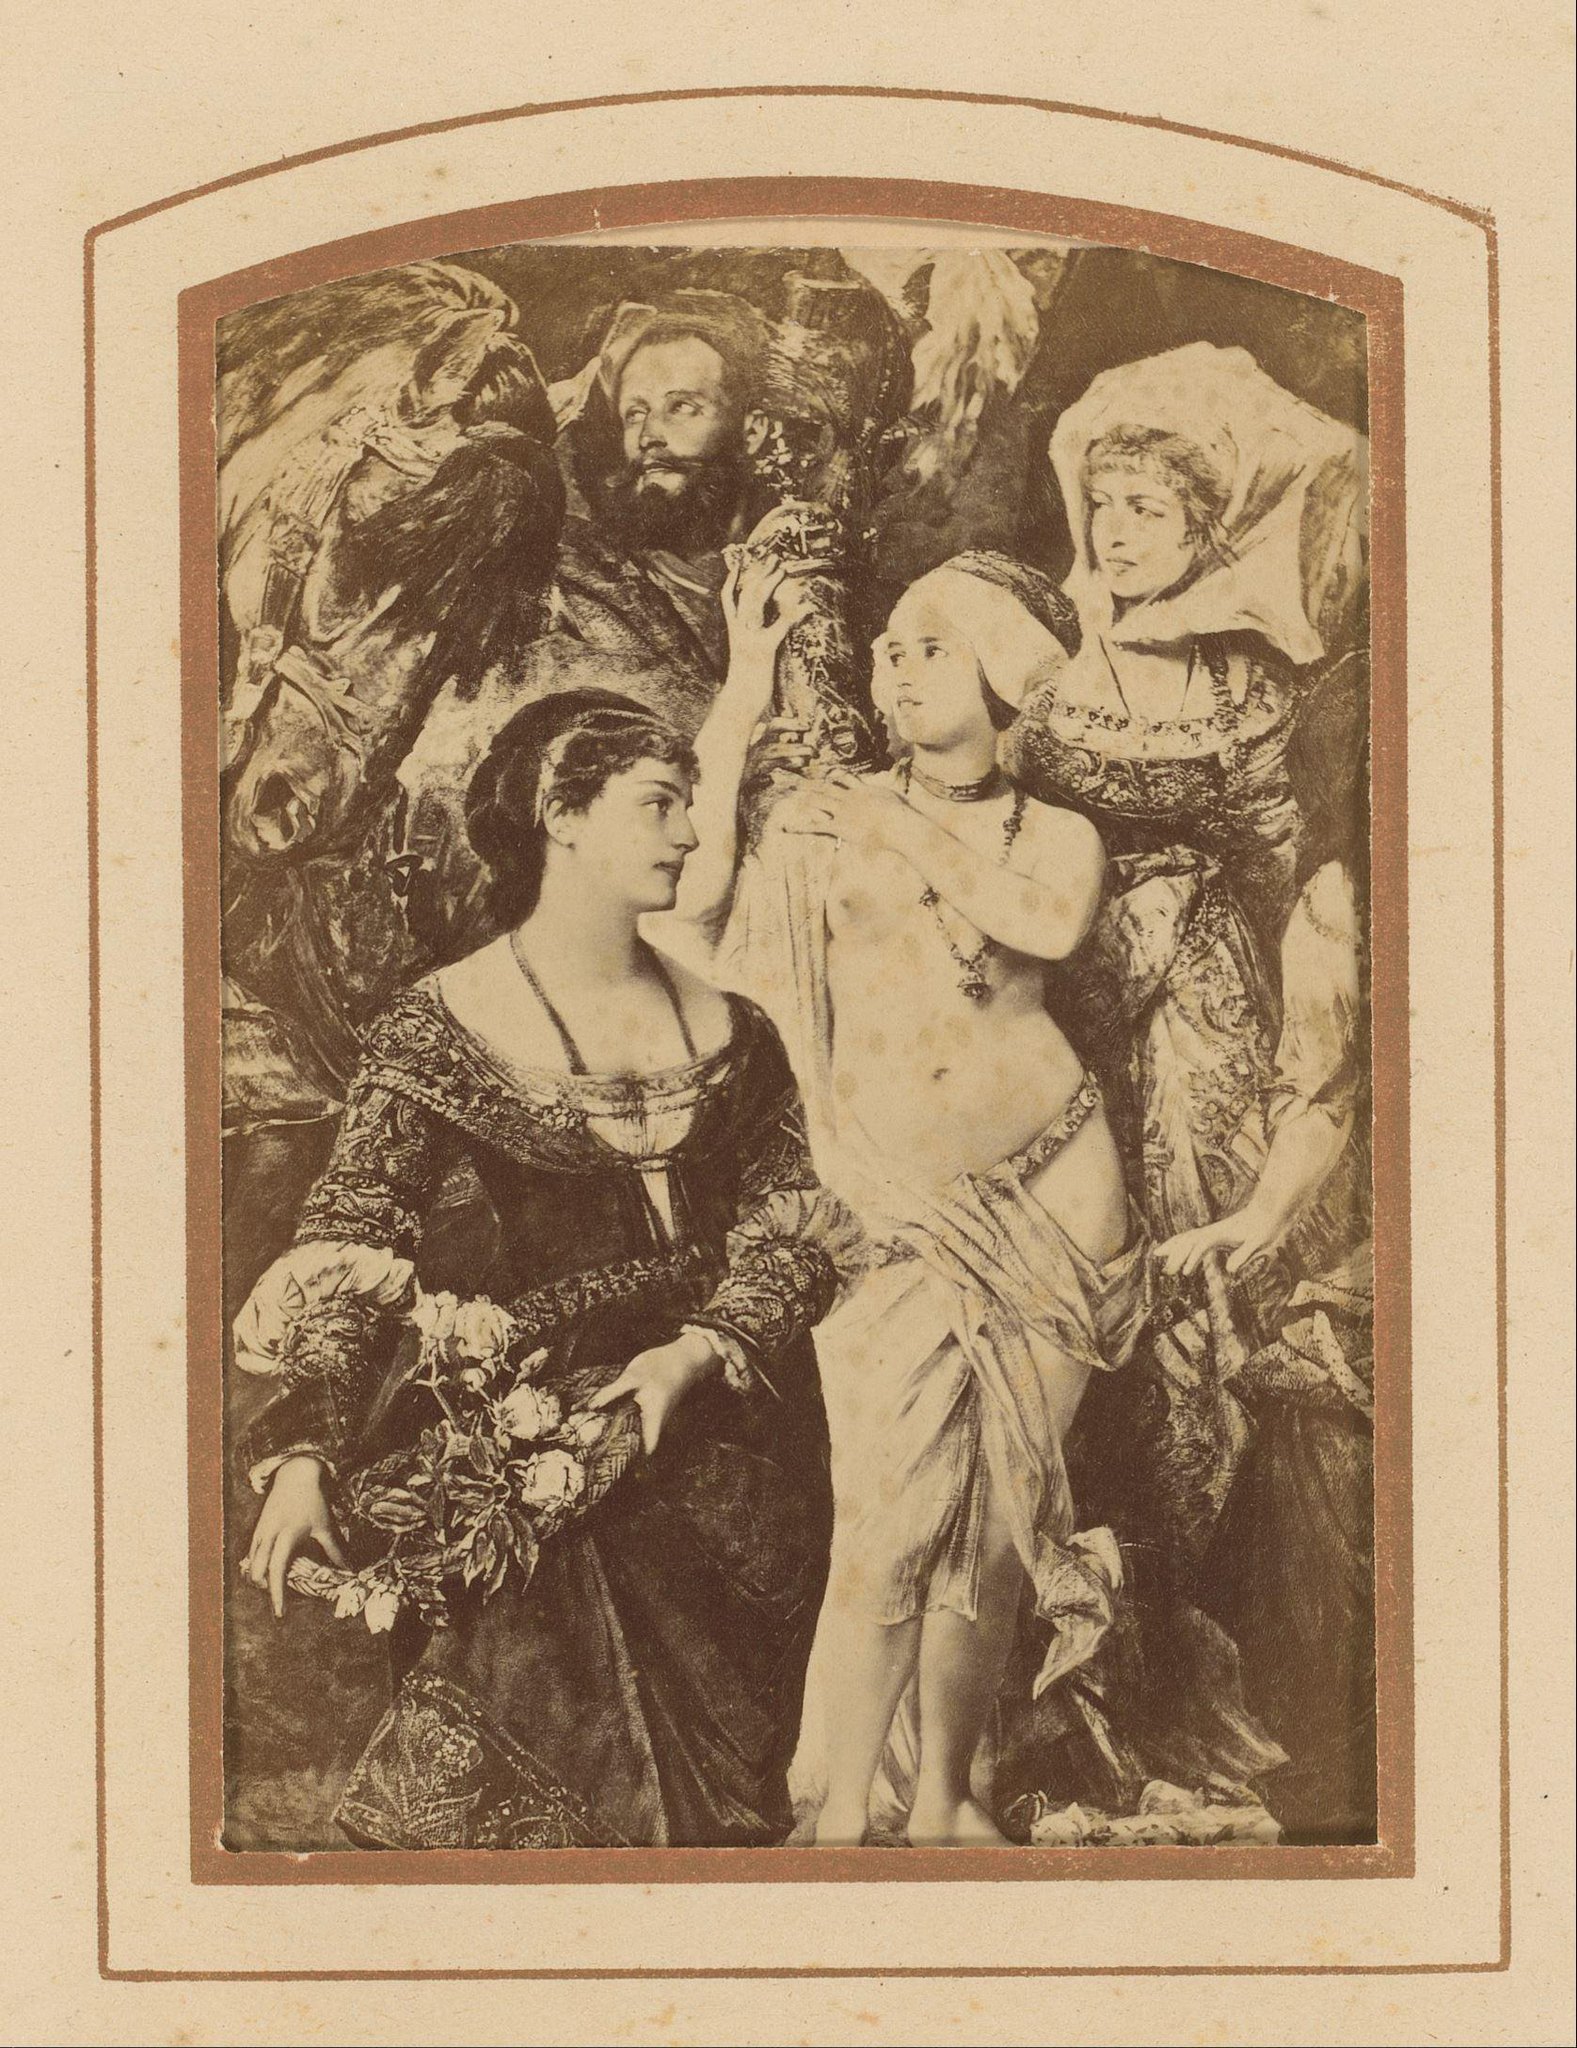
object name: reproduction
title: Fotoreproductie van een deel van een schilderij van de aankomst van Karel V in Antwerpen door Hans Makart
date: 1878-1900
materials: cardboard, photographic support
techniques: albumen print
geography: vienna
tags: being welcomed ~ travelling, ruler, sovereign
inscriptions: inscription: ‘VERVIELFÄLTIGUNG VORBHELATEN. 255. DEPOSÉ. REGISTERED.’